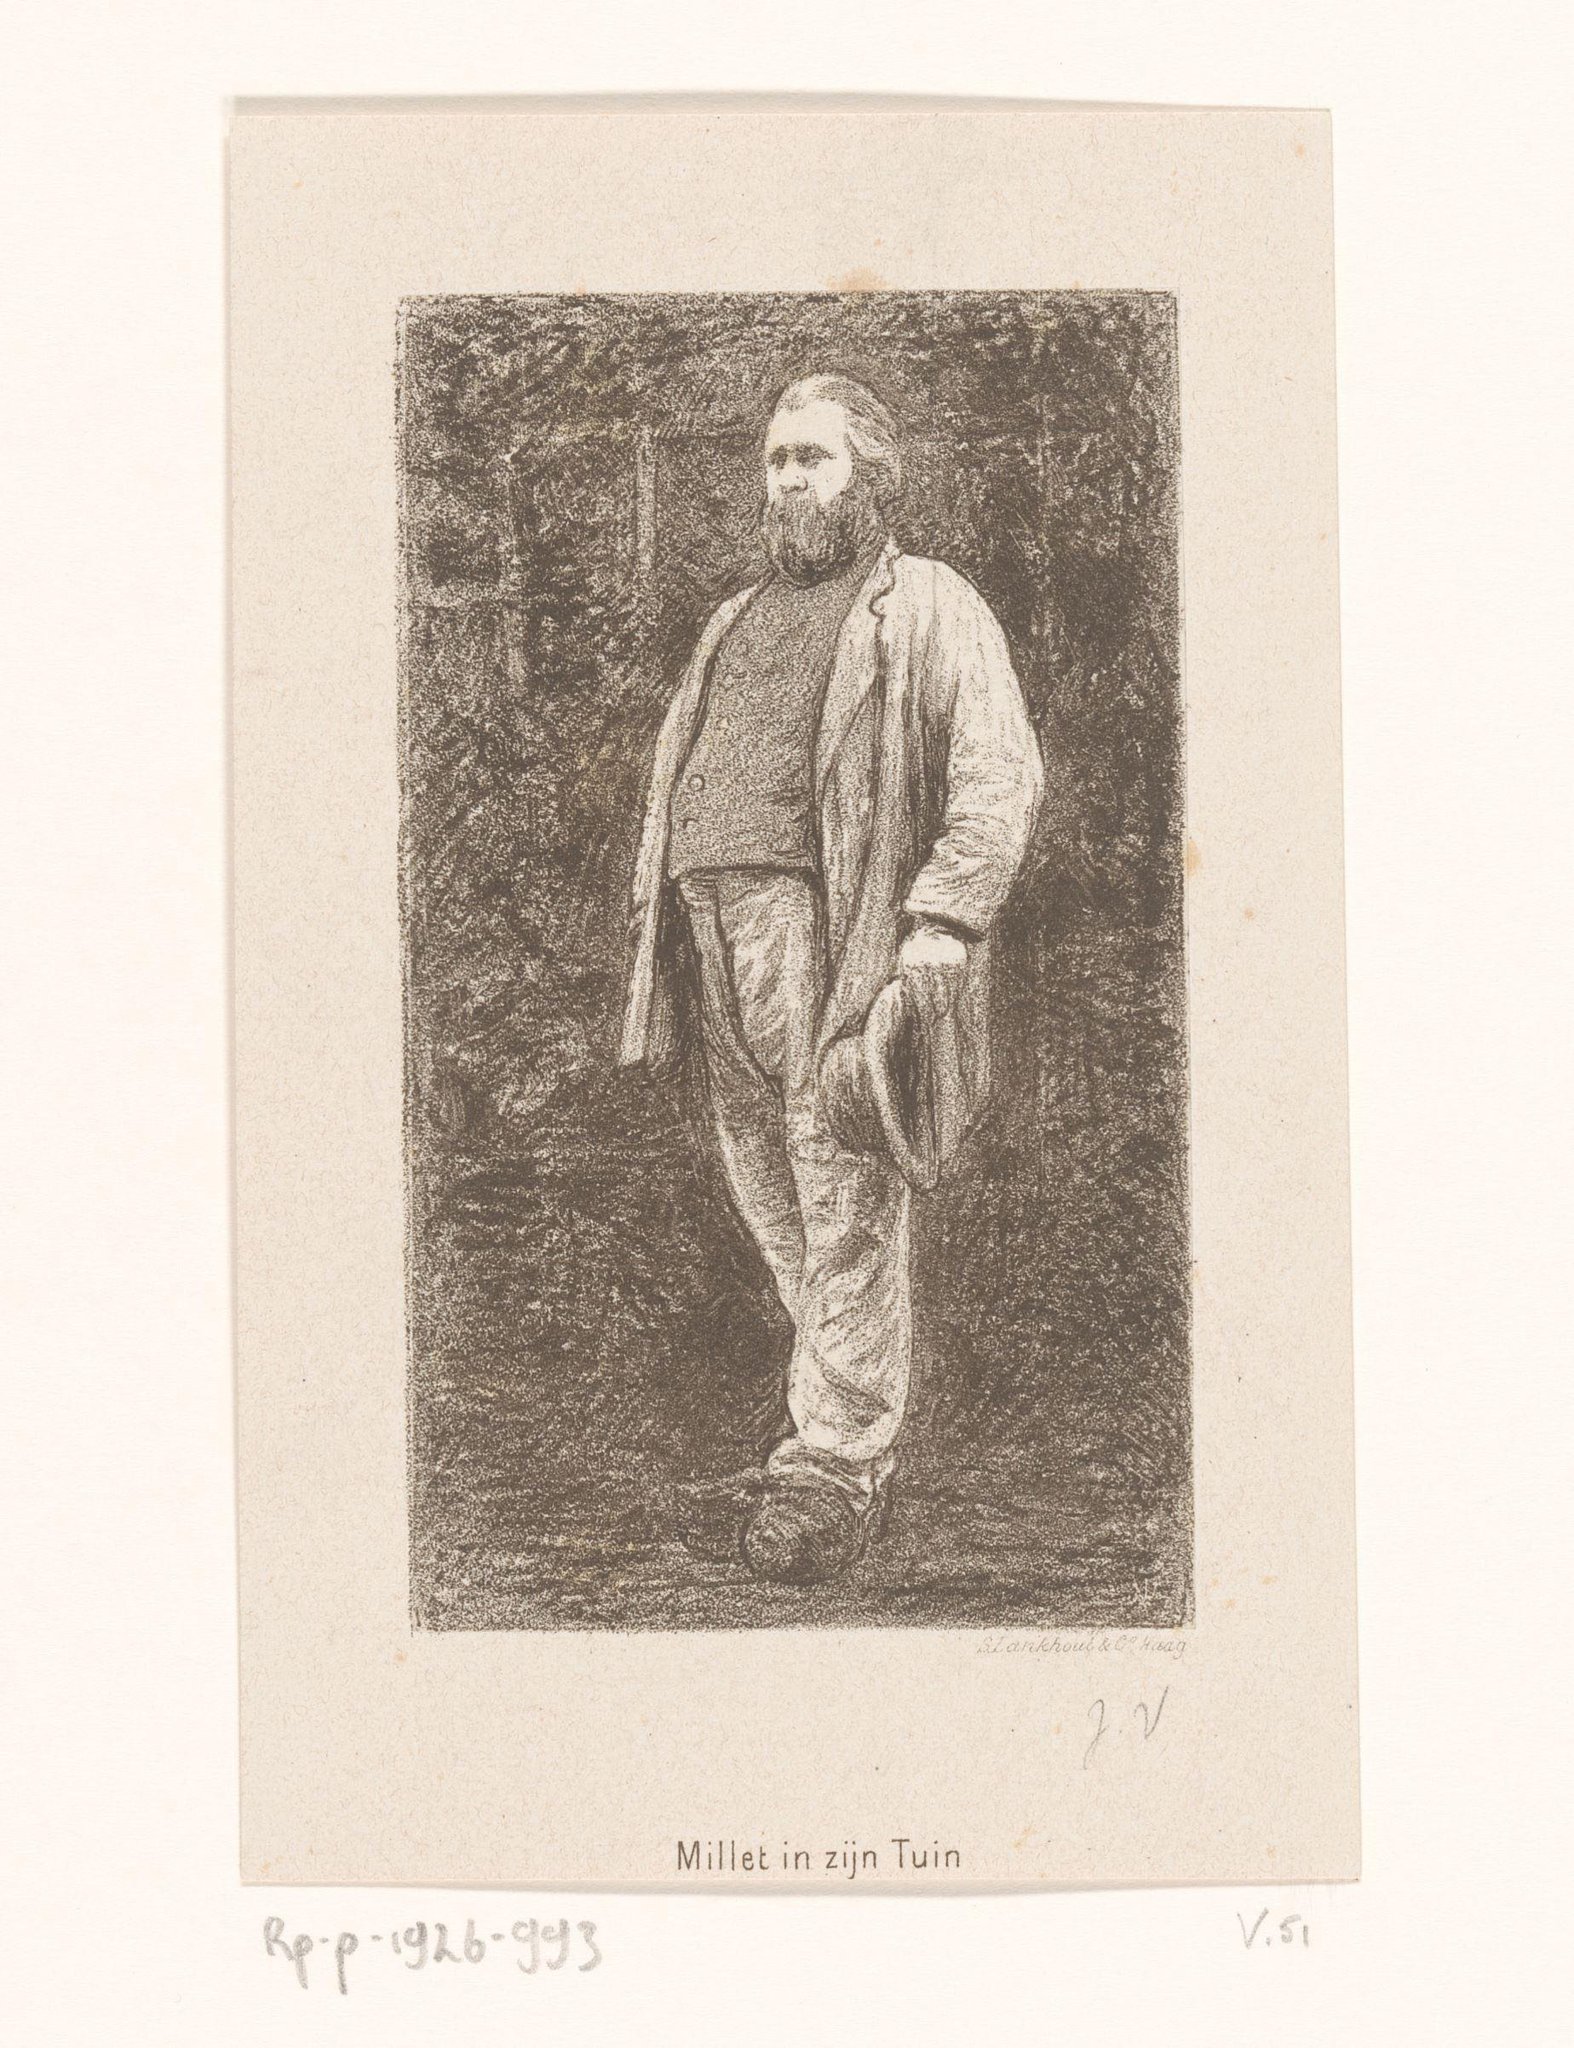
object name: print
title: Millet in zijn tuin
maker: jan veth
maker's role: designer, draughtsman, painter, print maker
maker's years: 1864-1925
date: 1890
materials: paper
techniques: lithograph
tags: jean françois millet, historical persons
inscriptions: collector's mark: Lugt 2228